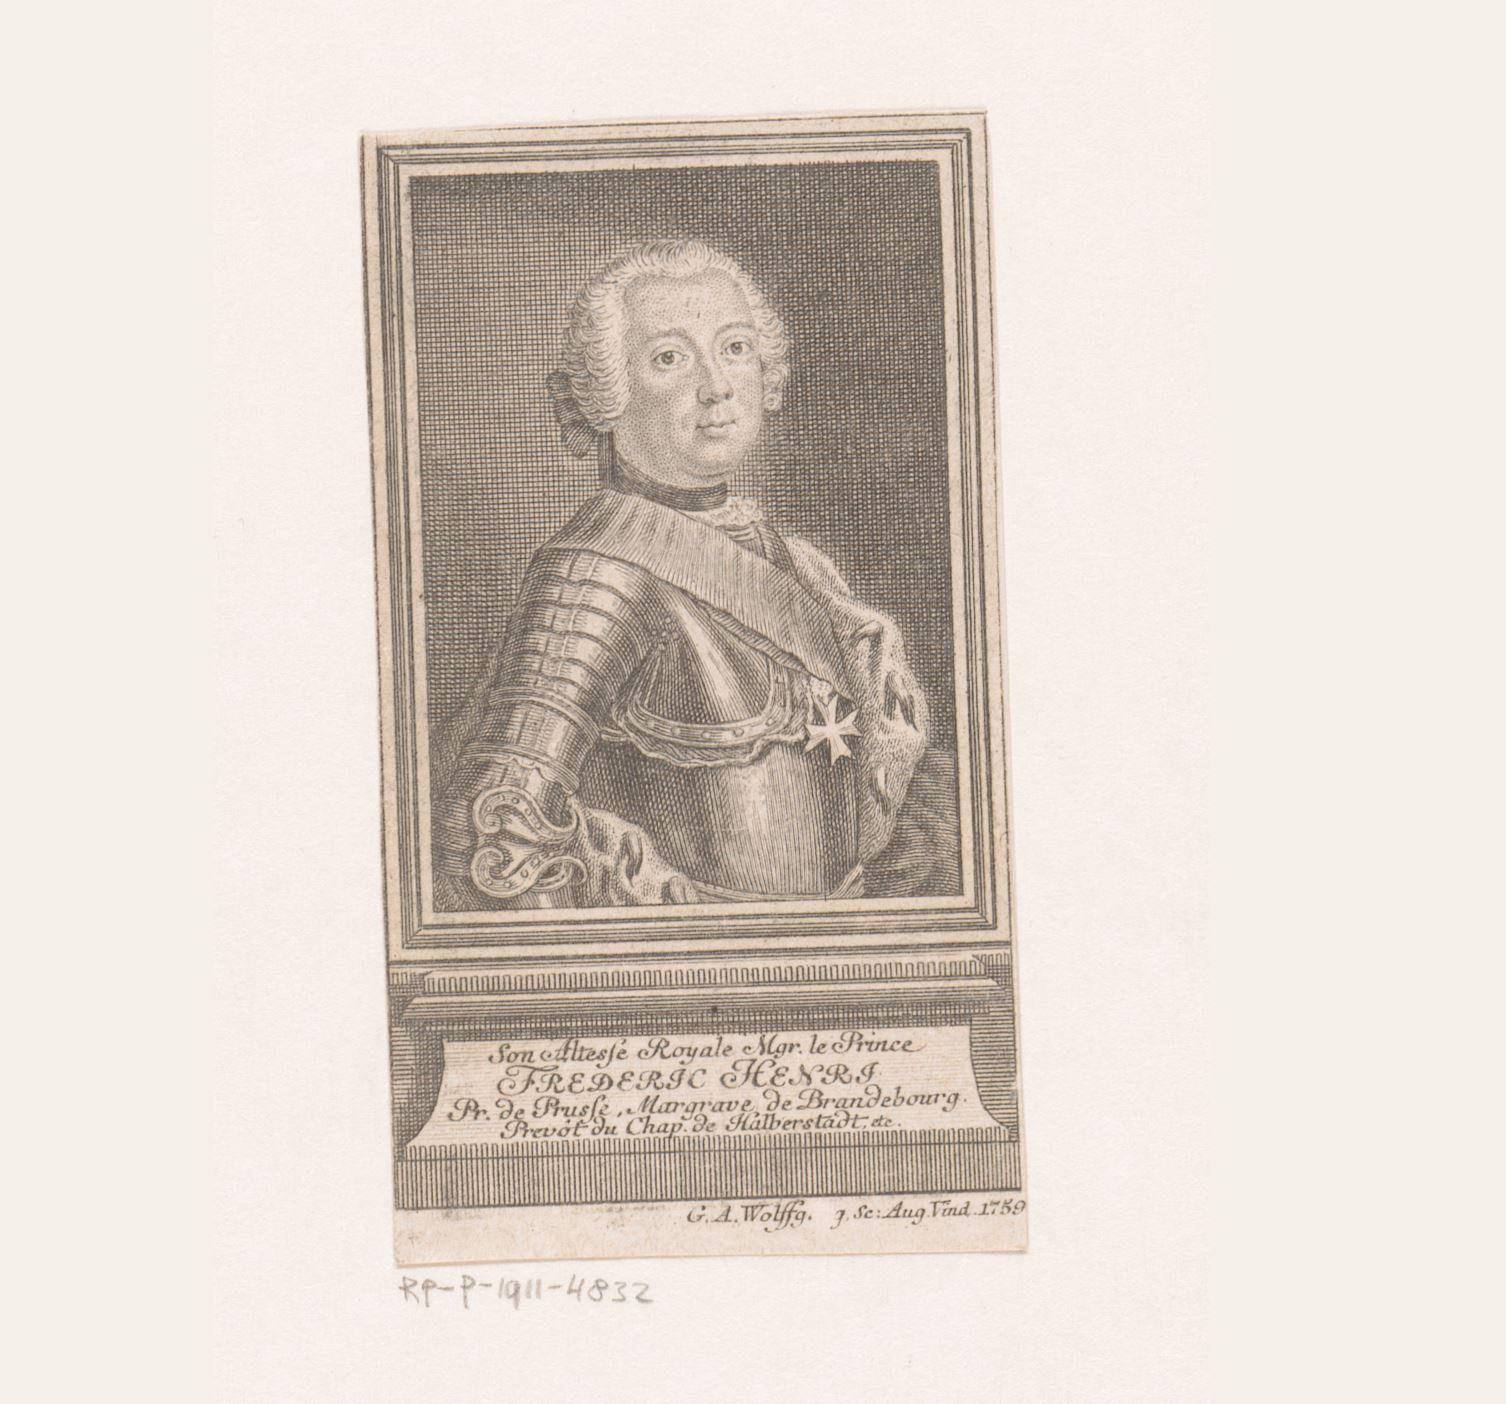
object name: print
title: Portret van Friedrich Heinrich, Markgraf von Brandenburg-Schwedt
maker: gustav andreas wolfgang (1692-1775)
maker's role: print maker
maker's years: 1692-1775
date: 1759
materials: paper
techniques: engraving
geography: augsburg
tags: historical persons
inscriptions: collector's mark: Lugt 2228